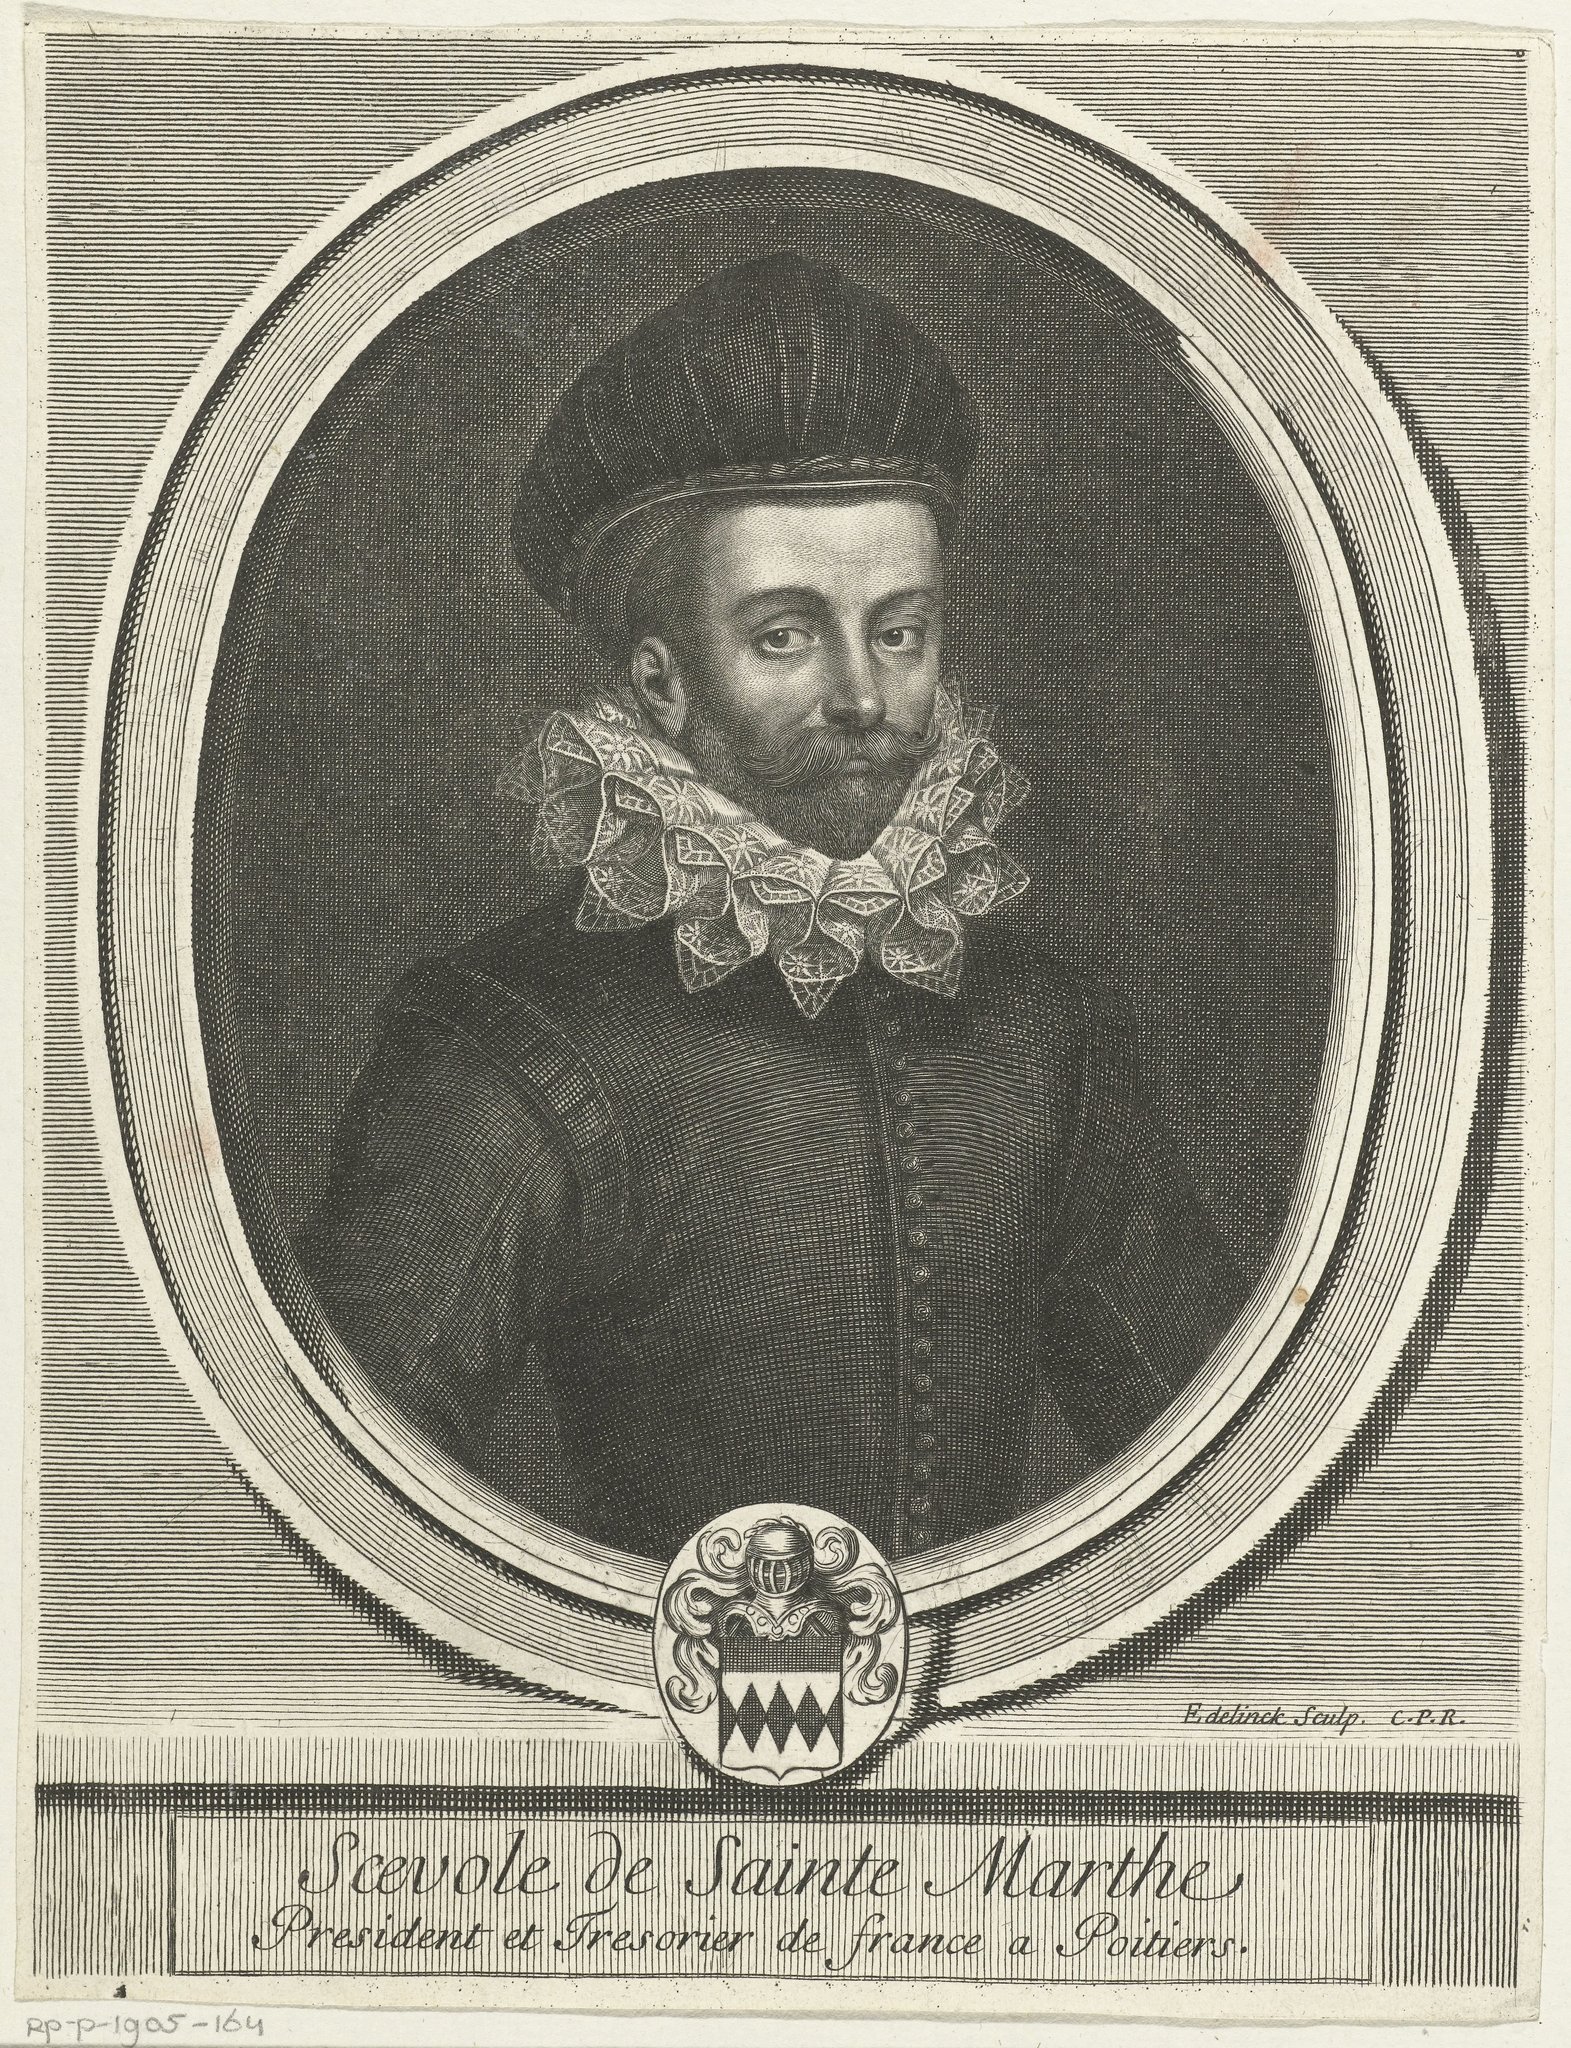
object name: print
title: Portret van Scévole de Sainte-Marthe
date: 1666-1707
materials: paper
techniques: engraving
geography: paris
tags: schrijver, scévole de sainte-marthe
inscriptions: collector's mark: Lugt 2228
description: Portret van de Franse dichter en penningmeester Scévole de Sainte-Marthe (1536-1623), afgebeeld in ovale omlijsting met wapen.